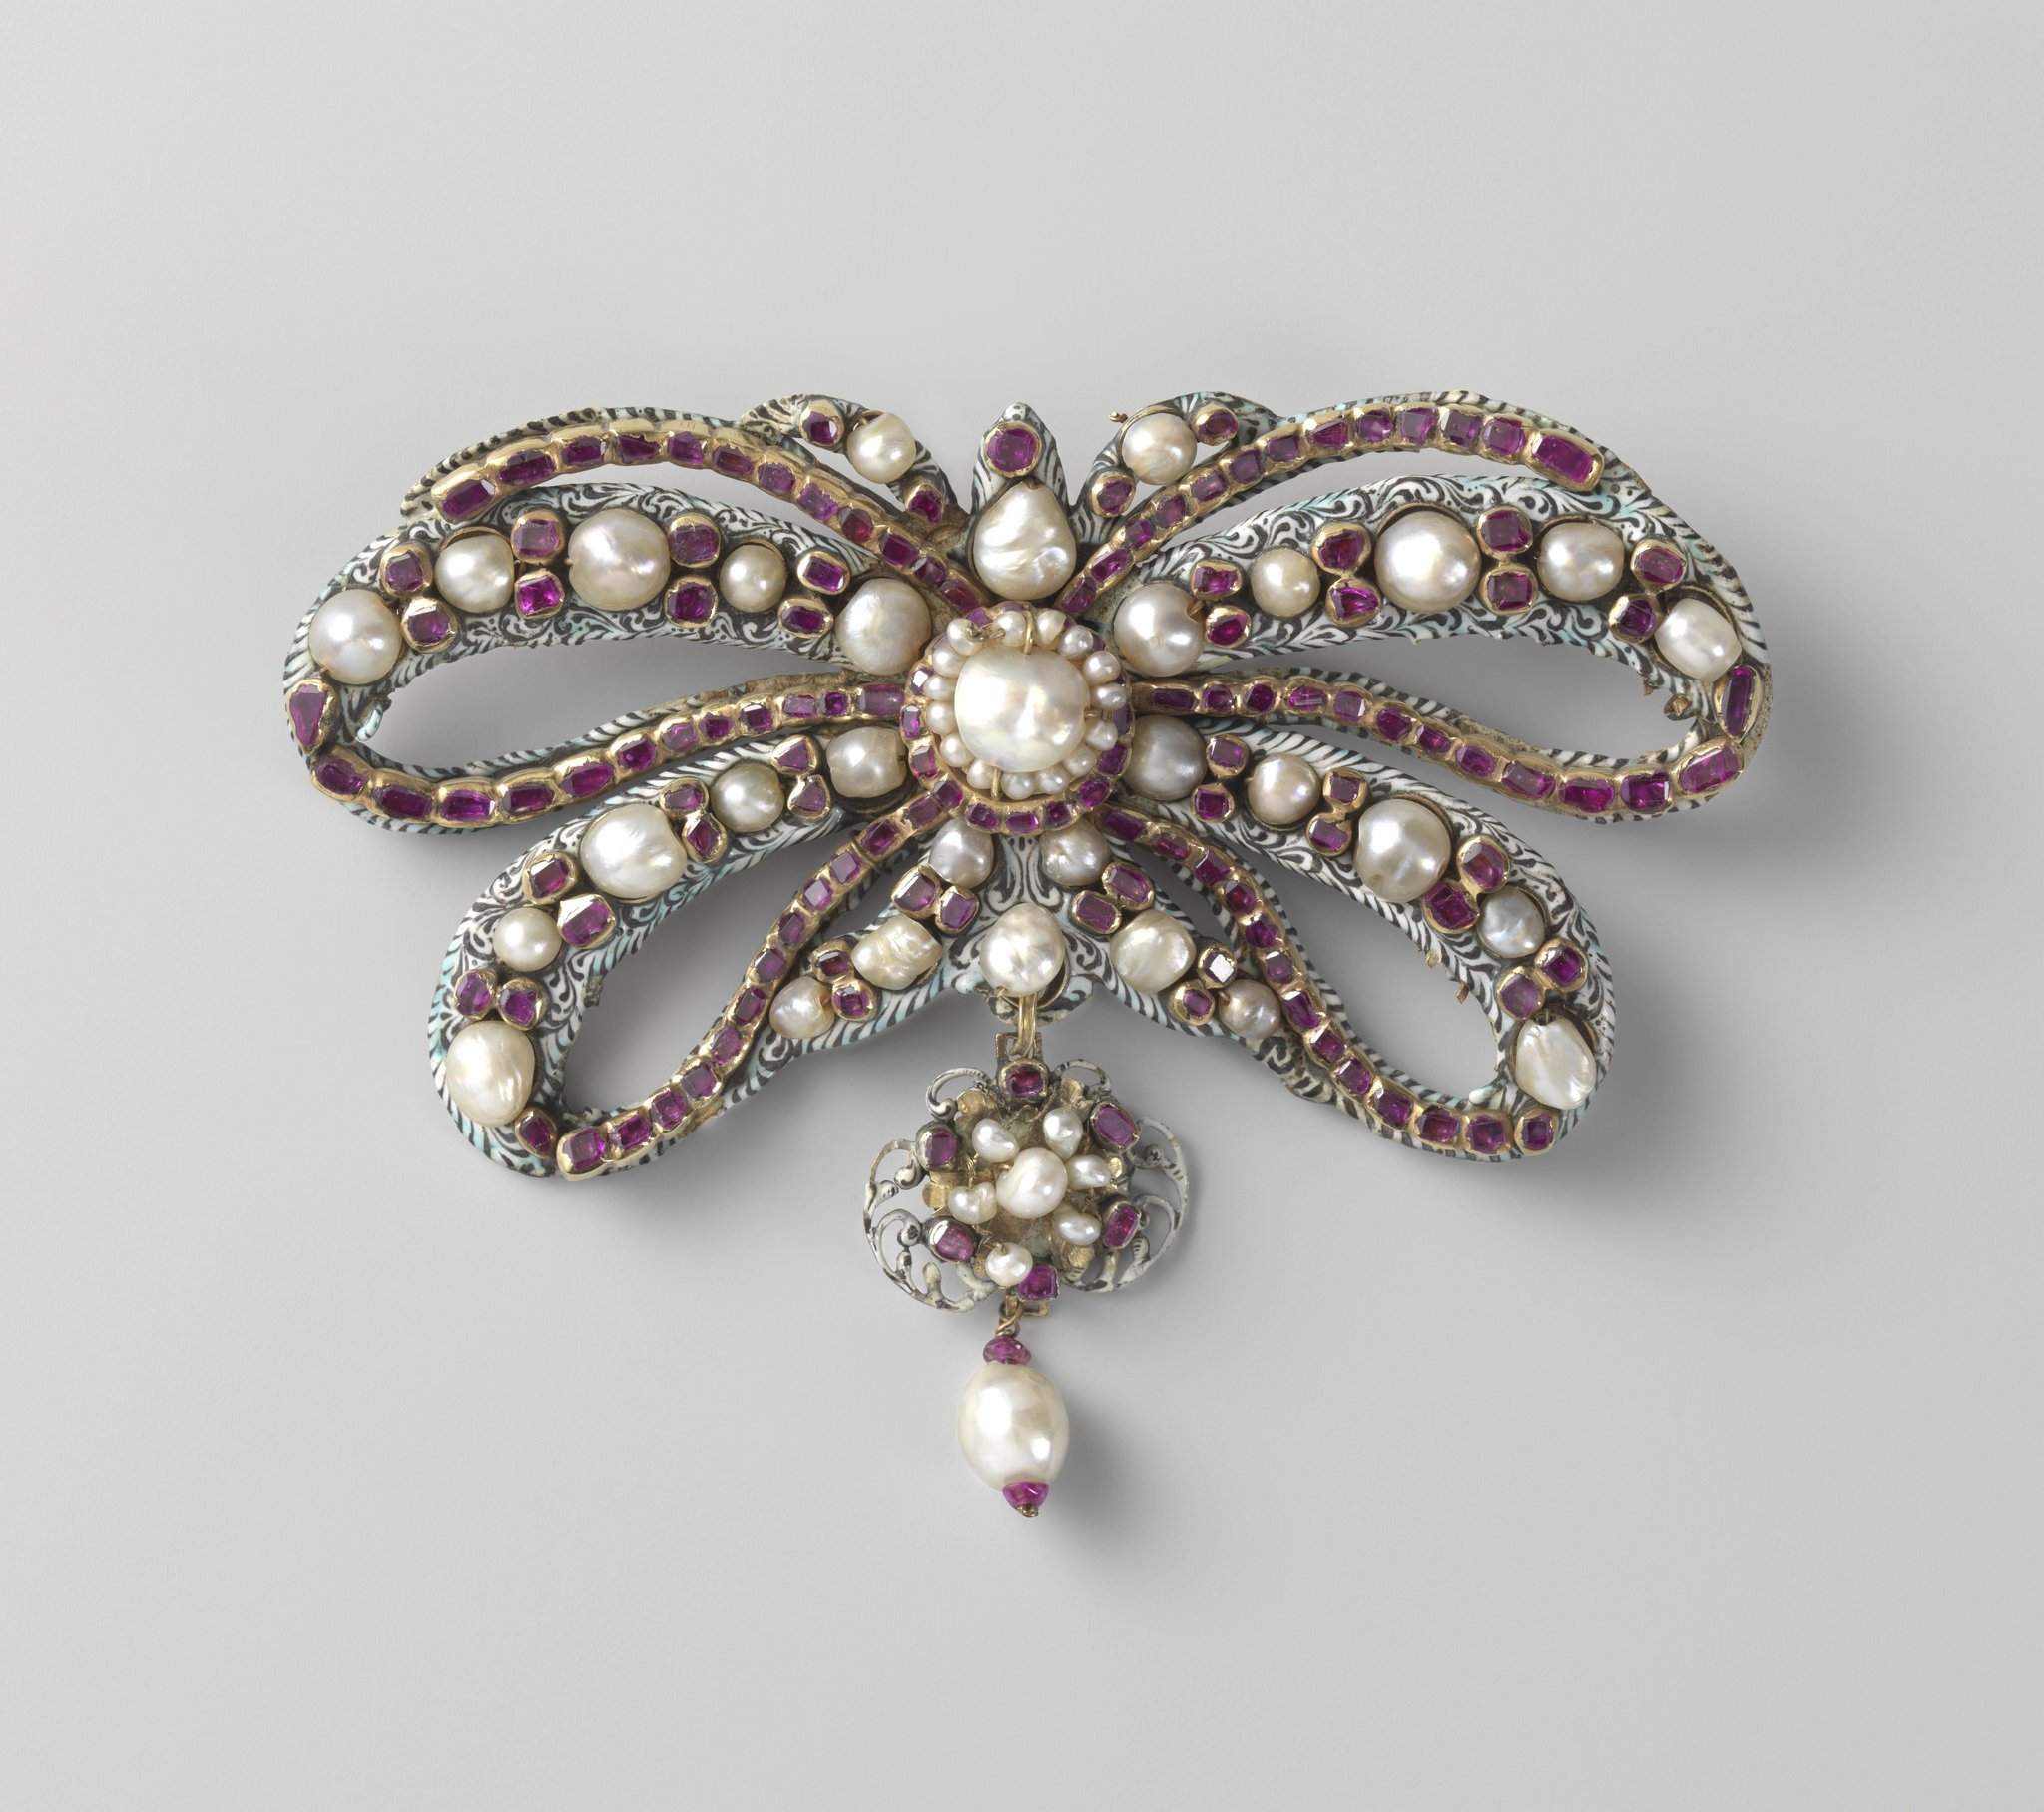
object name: jewellery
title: Bow brooch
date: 1650-1675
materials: gold, pearl, gemstone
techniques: enameling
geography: netherlands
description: The shape of this brooch is known from a design that the jeweller to the French king Louis XIV made in 1663. It is a bow-knot in gold, which is enamelled and set with precious stones. Double bows were worn by the wealthiest of women. Amalia of Solms, the Dutch Stadtholder Frederick Henry’s consort, sports a brooch of this type in several portraits.